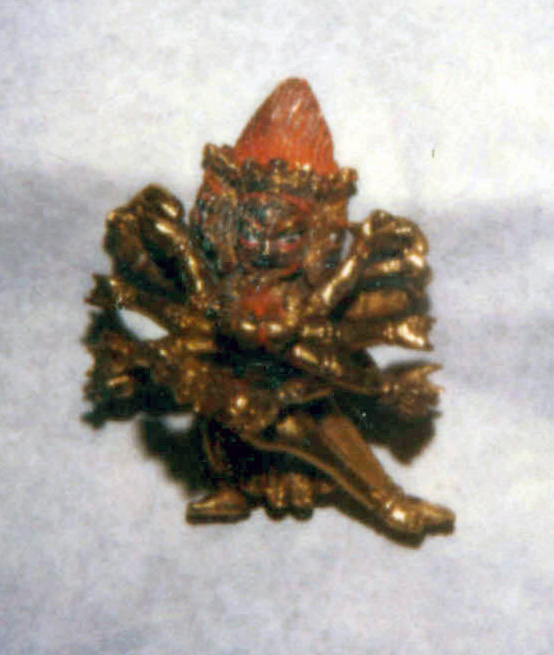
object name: figure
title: Mahakala with Shakti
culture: nepali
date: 1701-1900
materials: enamel, gold